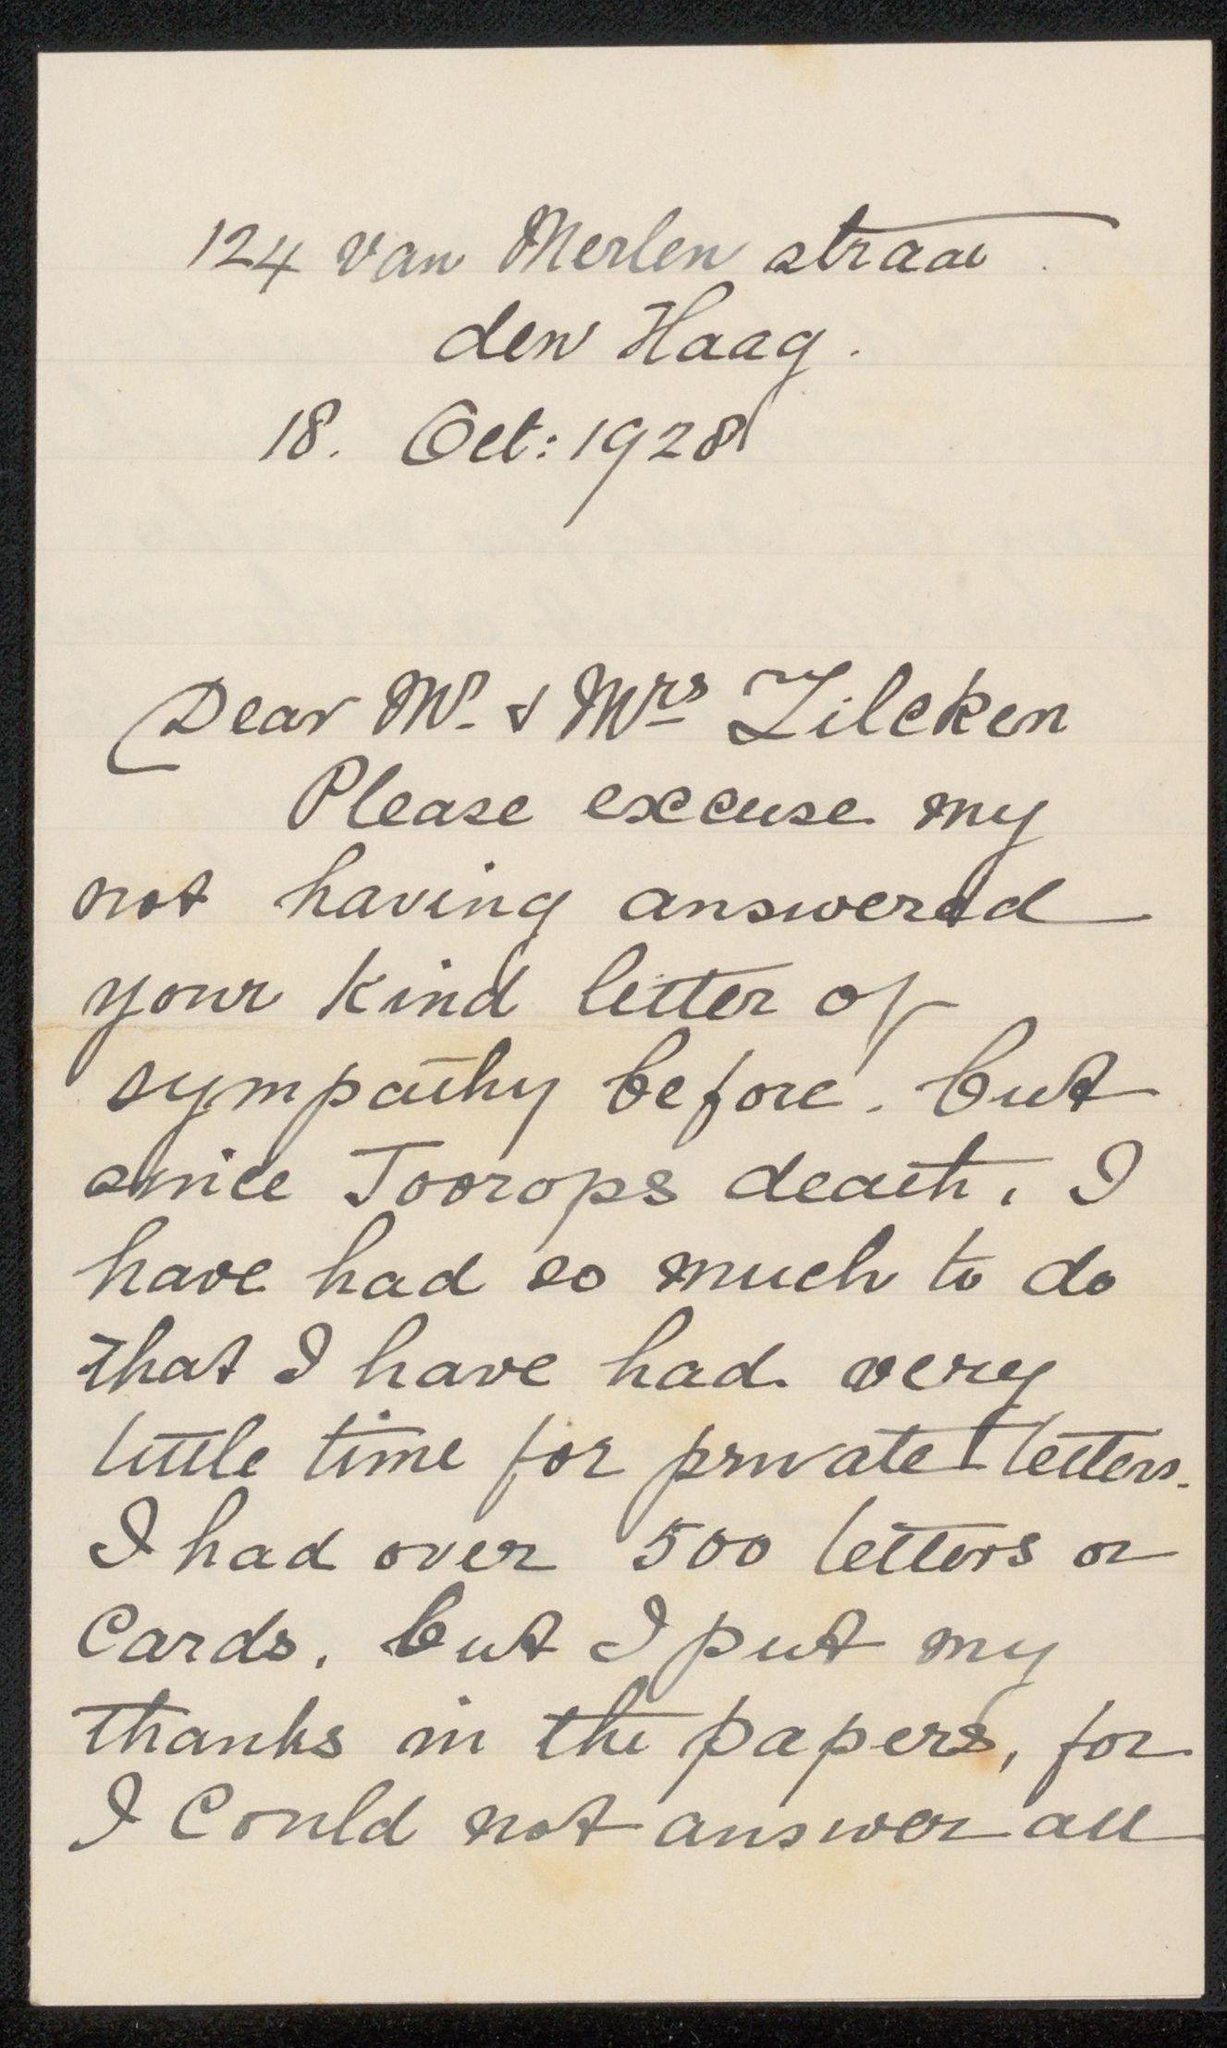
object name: letter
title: Brief aan Philip Zilcken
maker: annie toorop-hall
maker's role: draughtsman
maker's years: 1860-1929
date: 1928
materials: ink, paper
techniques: pen, writing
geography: the hague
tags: charley toorop, voorburg, print maker, renée hélène laure zilcken, jan toorop, philip zilcken, printed matter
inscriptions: name: ‘Mevrouw Toorop.’, collector's mark: ‘RPK’